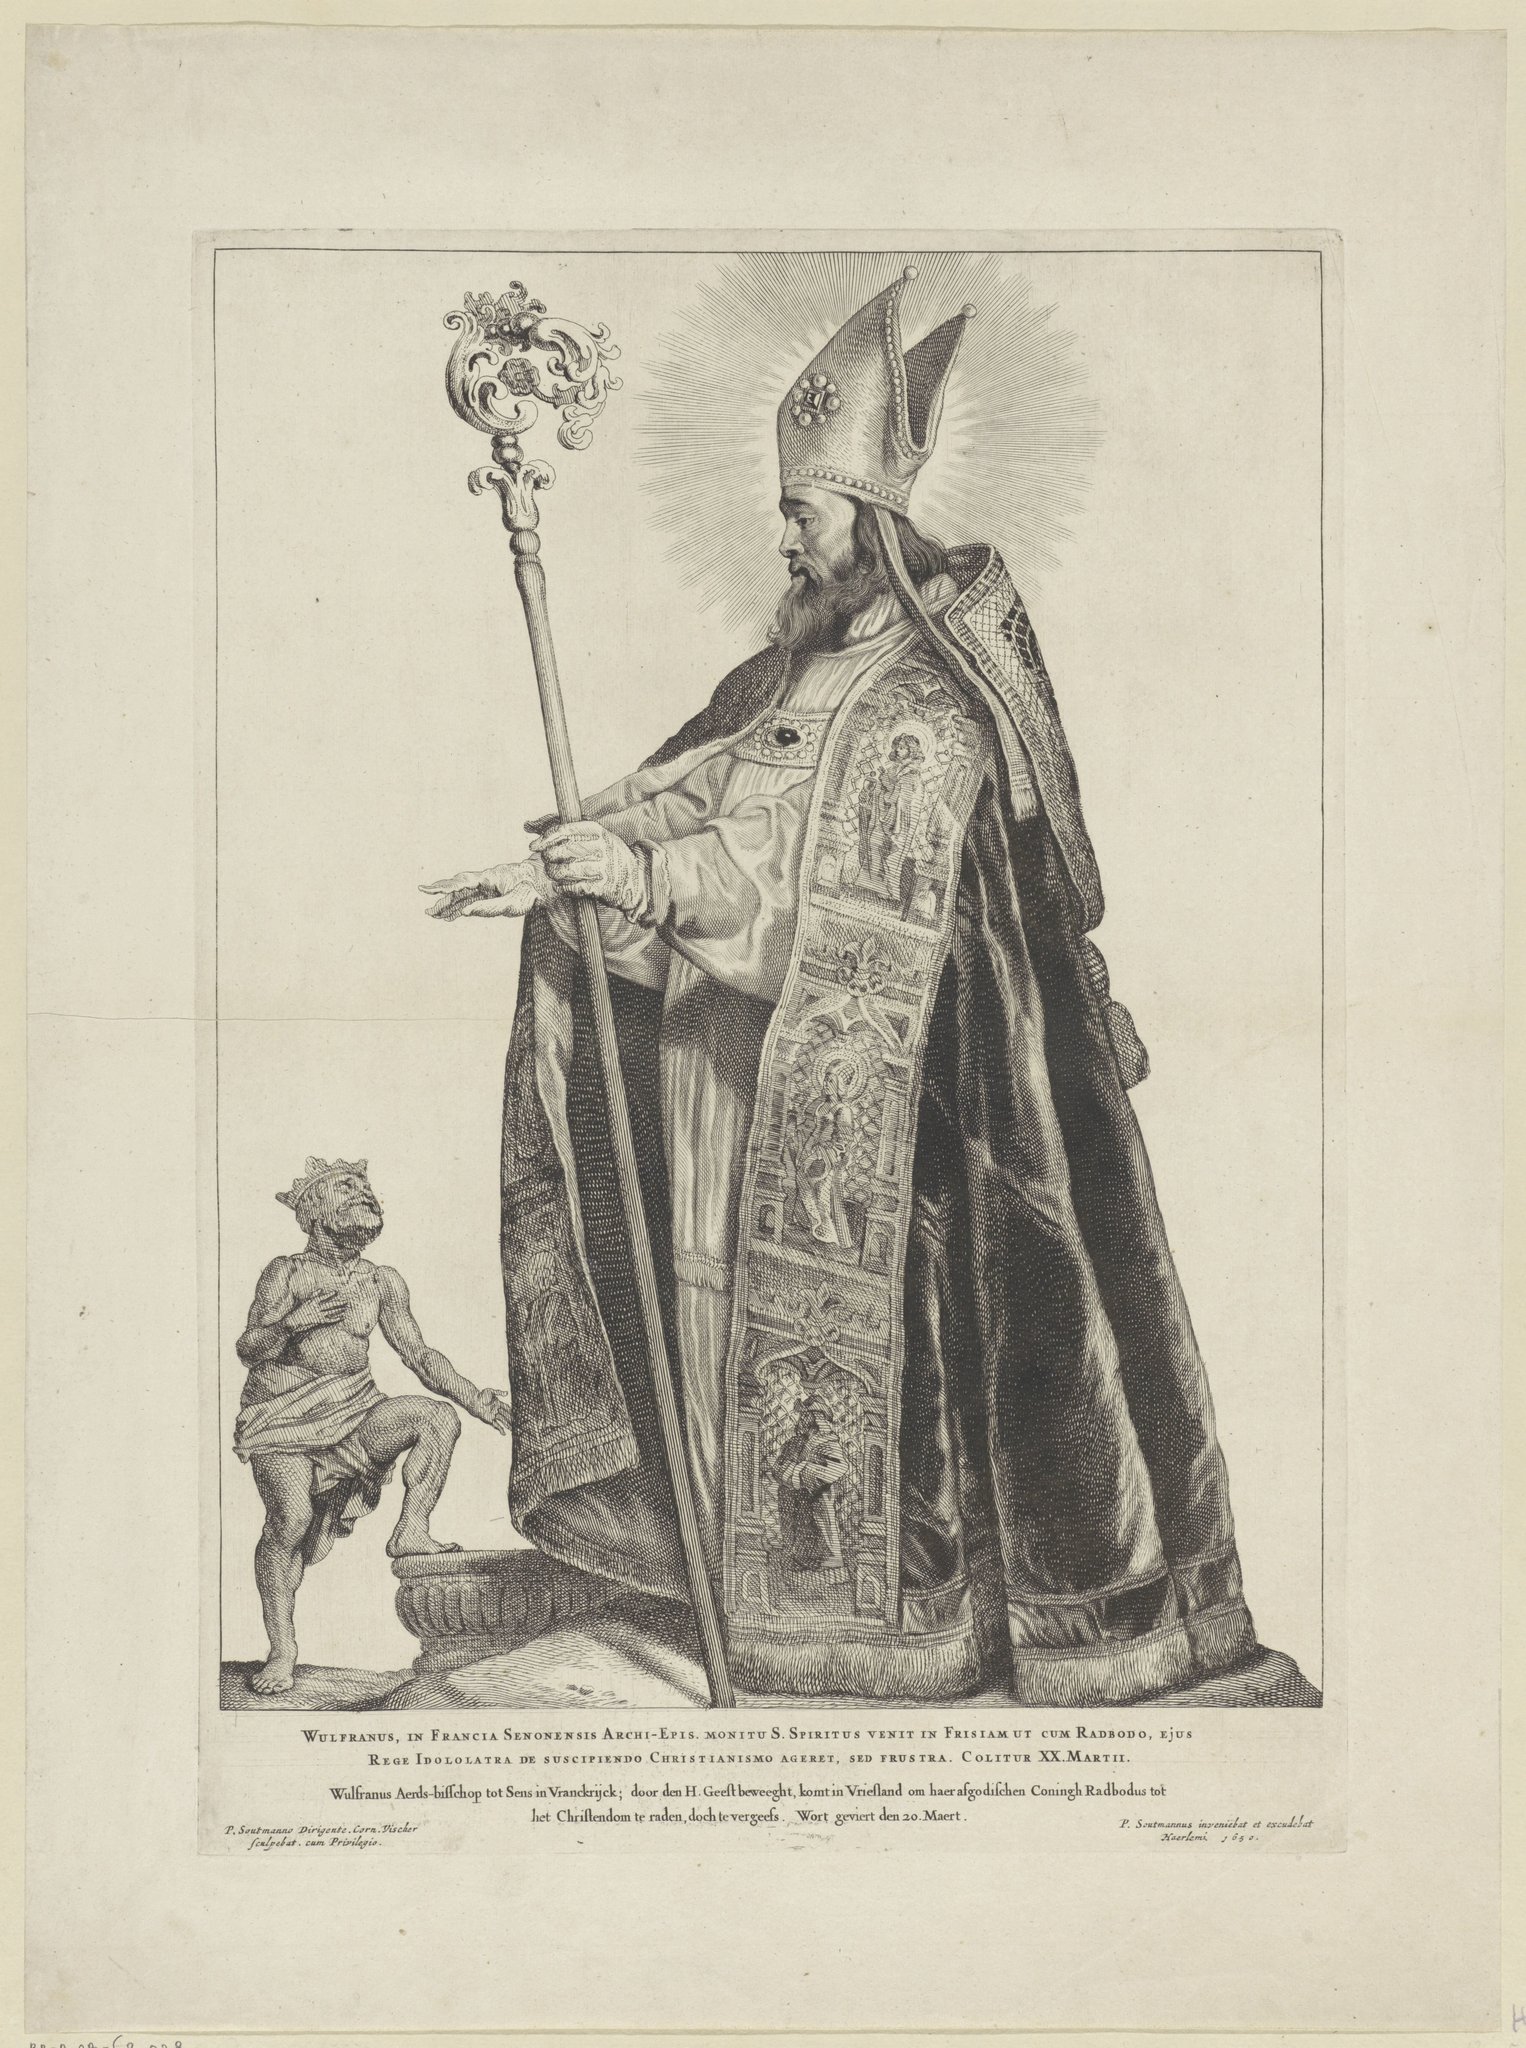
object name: print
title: H. Wolframus van Sens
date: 1650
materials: paper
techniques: engraving, etching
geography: haarlem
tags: heilige, wolframus van sens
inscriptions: collector's mark: Lugt 240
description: Deze prent maakt deel uit van de serie: Iesv Christo, Fideli Militantis Ecclesiae Imperatori, Liberali Eivsdem, Trivmphantis, Remvneratori, hos In Foederato Belgio Militiae Svae Legatos, Sanctissimos Sacri Belli Dvces, Patriae Apostolos, Et Decora Lvmina, Cvm Dvabvs Heroinis, Militans In Iisdem Provinciis Ecclesia. Haarlem: Pieter Claesz. Soutman, 1650.